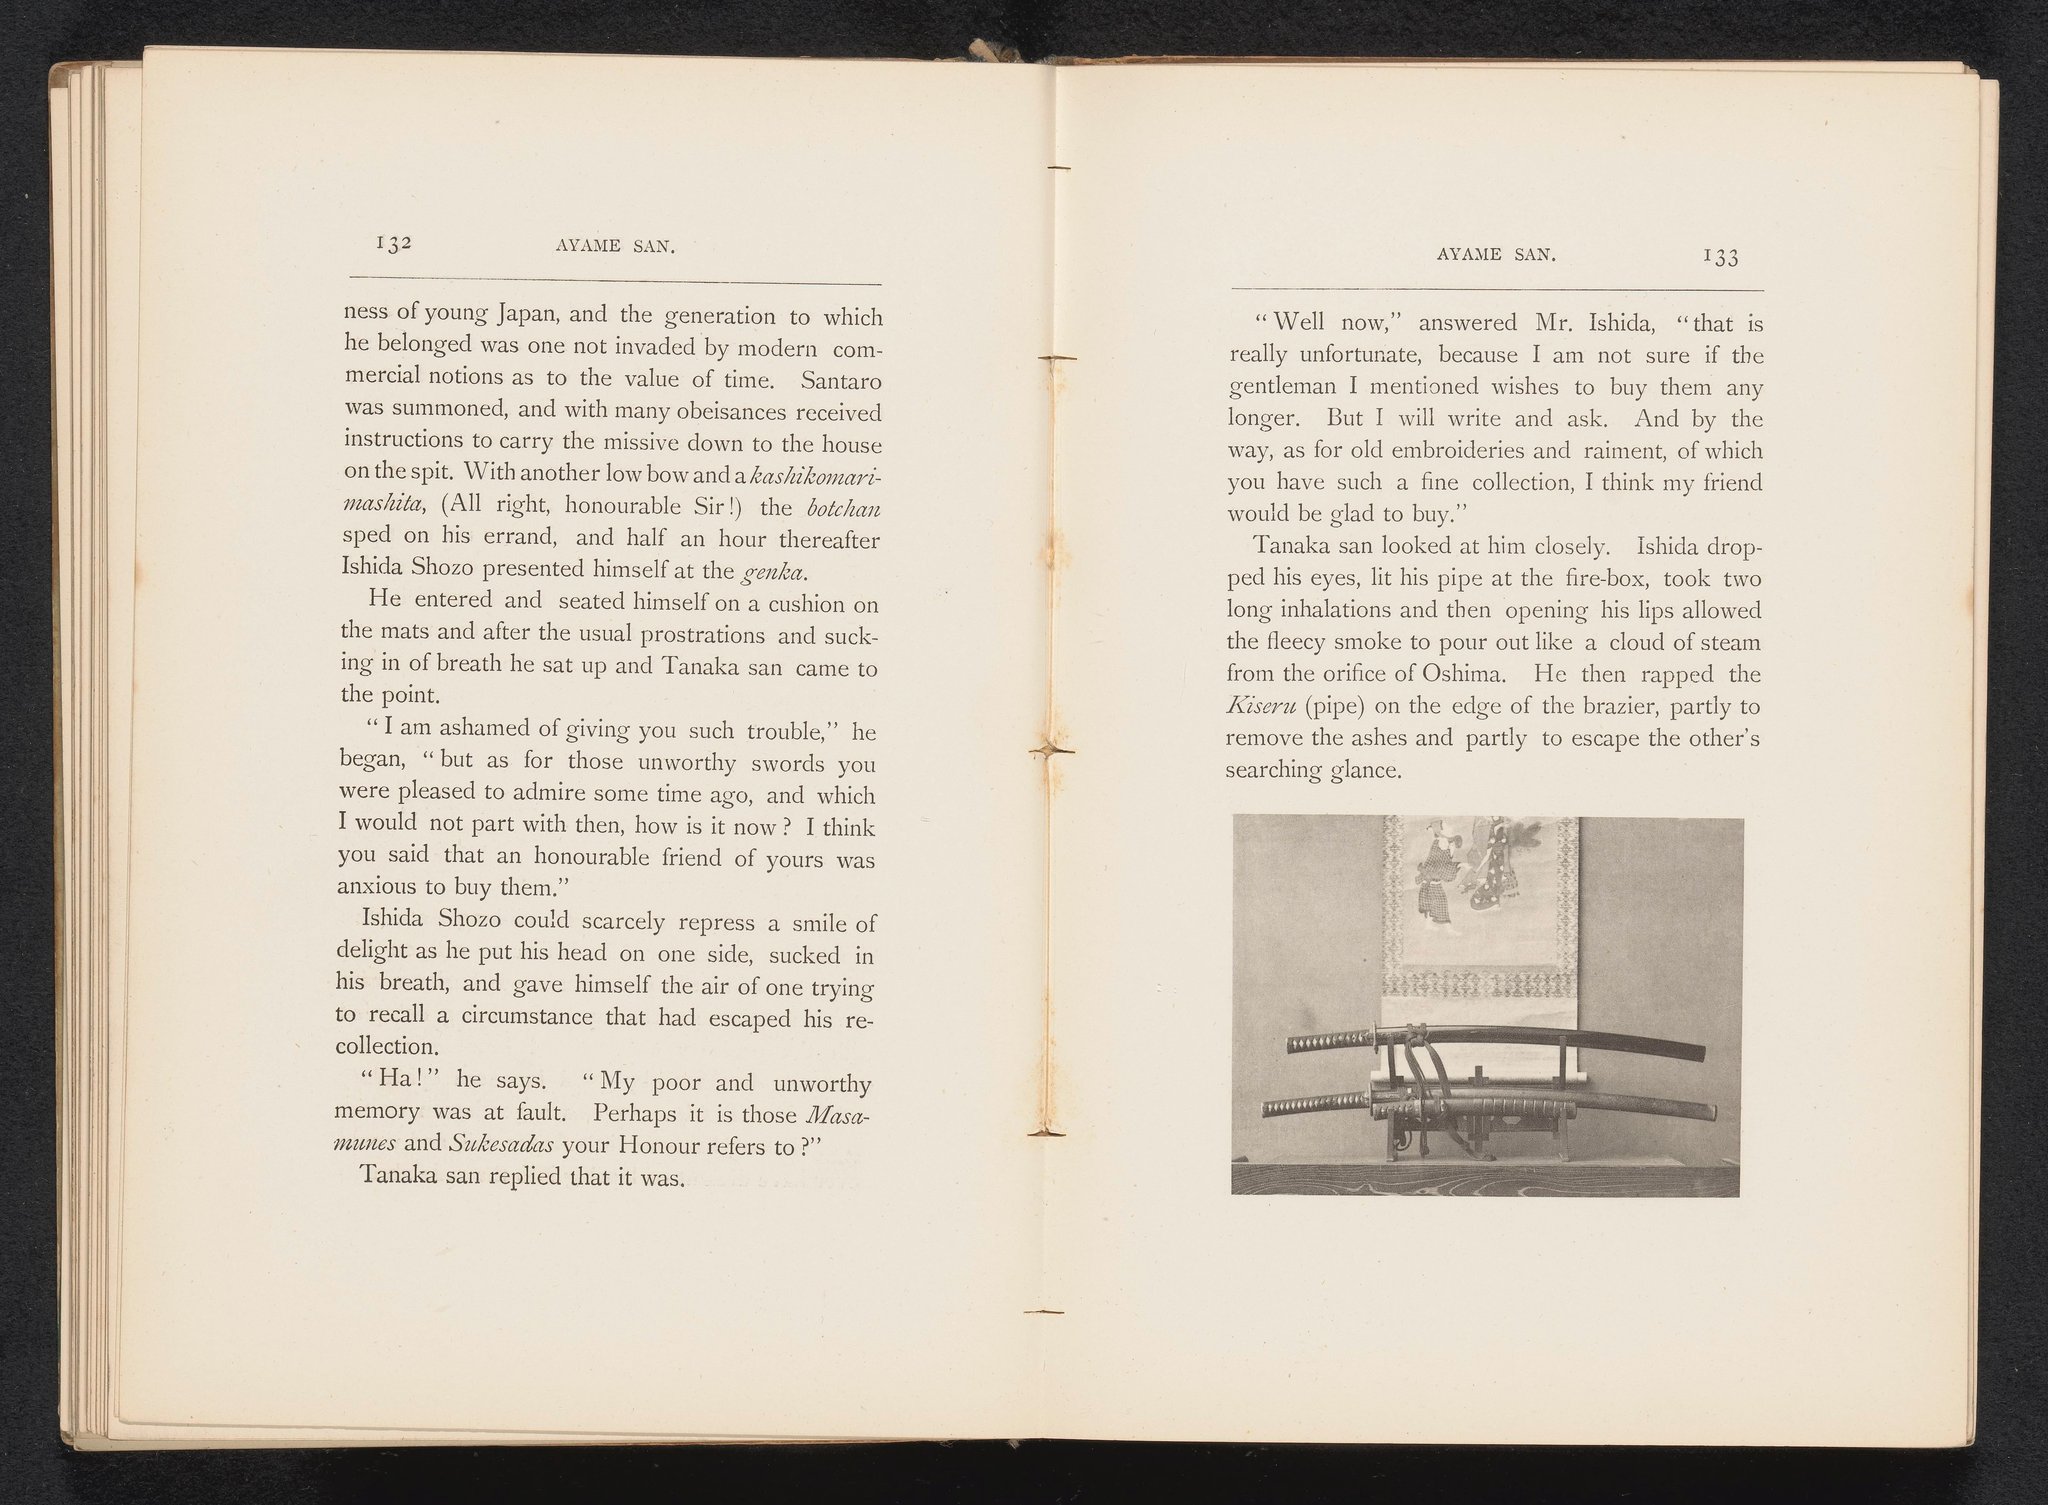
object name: page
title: Twee katana's in een interieur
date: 1882-1892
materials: paper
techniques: photograph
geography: japan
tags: hacking and thrusting weapons: sword, interior ~ representation of a building